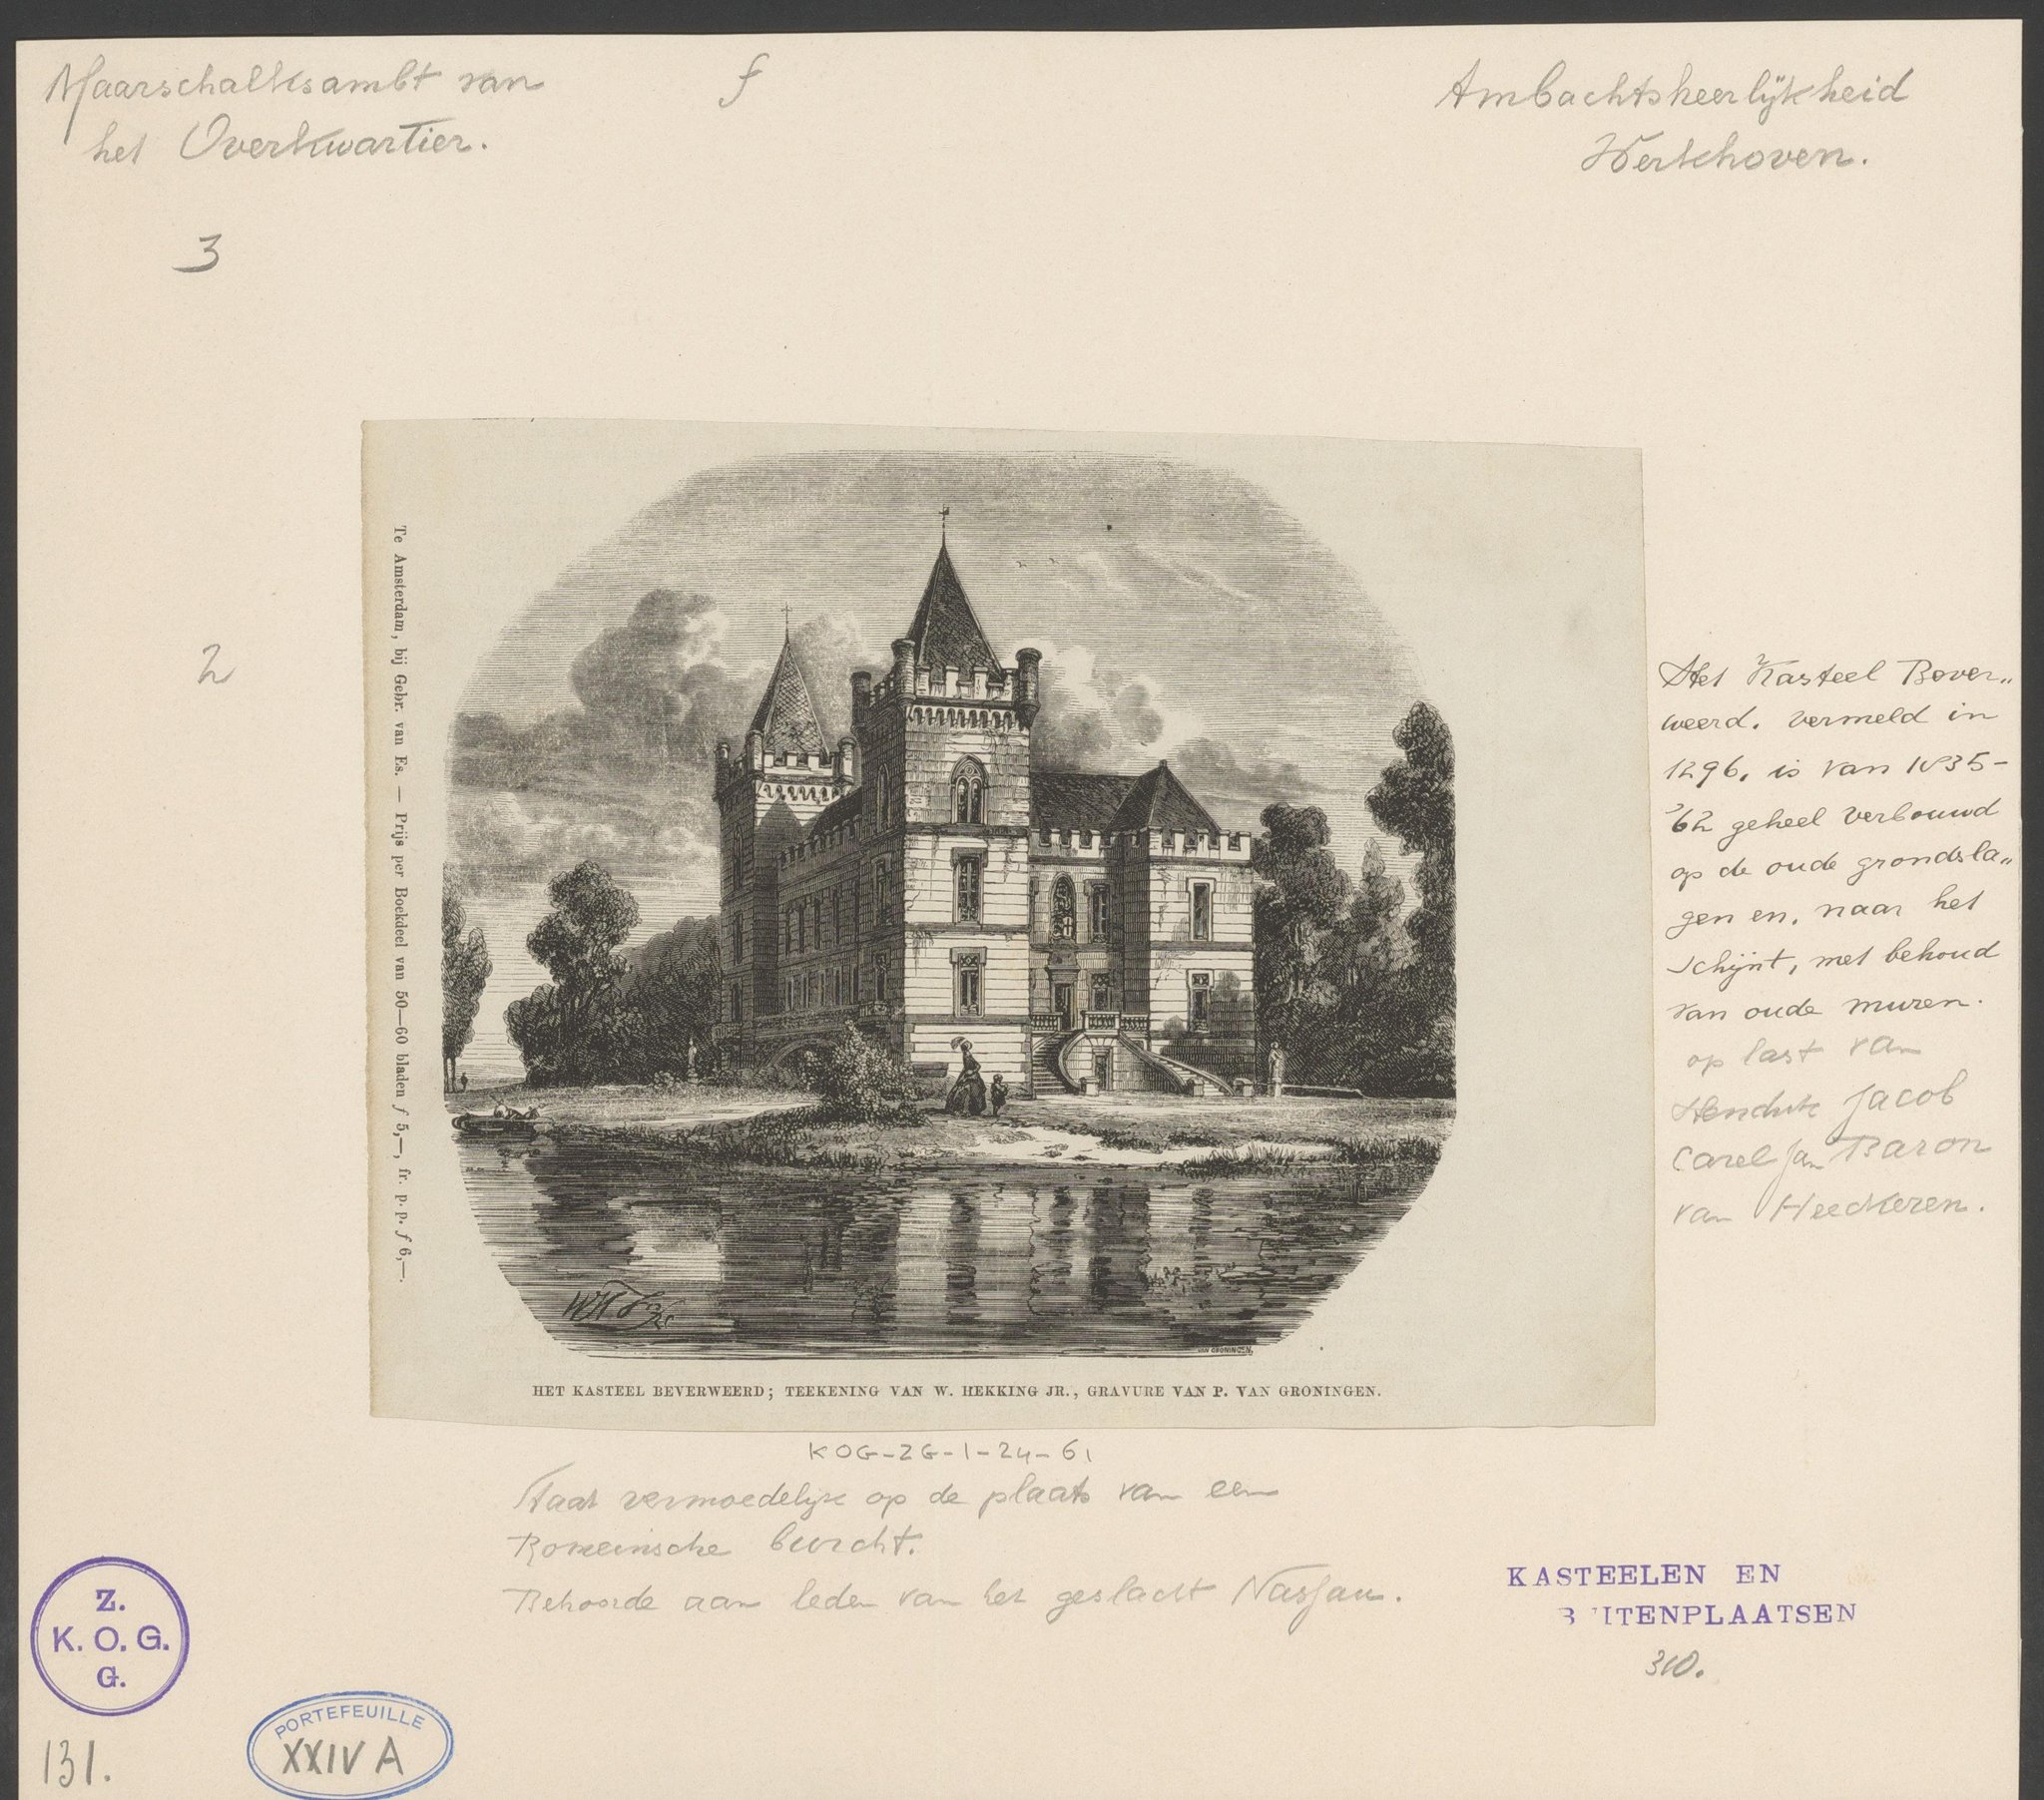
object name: print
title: Gezicht op Kasteel Beverweerd aan de Kromme Rijn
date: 1860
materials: paper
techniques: letterpress printing, engraving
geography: amsterdam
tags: castle, river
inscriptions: stamp, stamp, collector's mark: Lugt 1641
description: Onderwerpsrubrieken binnen de Atlas Zeden en Gewoonten: Zeden en Gewoonten in Engeren Zin, De Woning. Kastelen en buitenplaatsen. Utrecht (vervolg.).